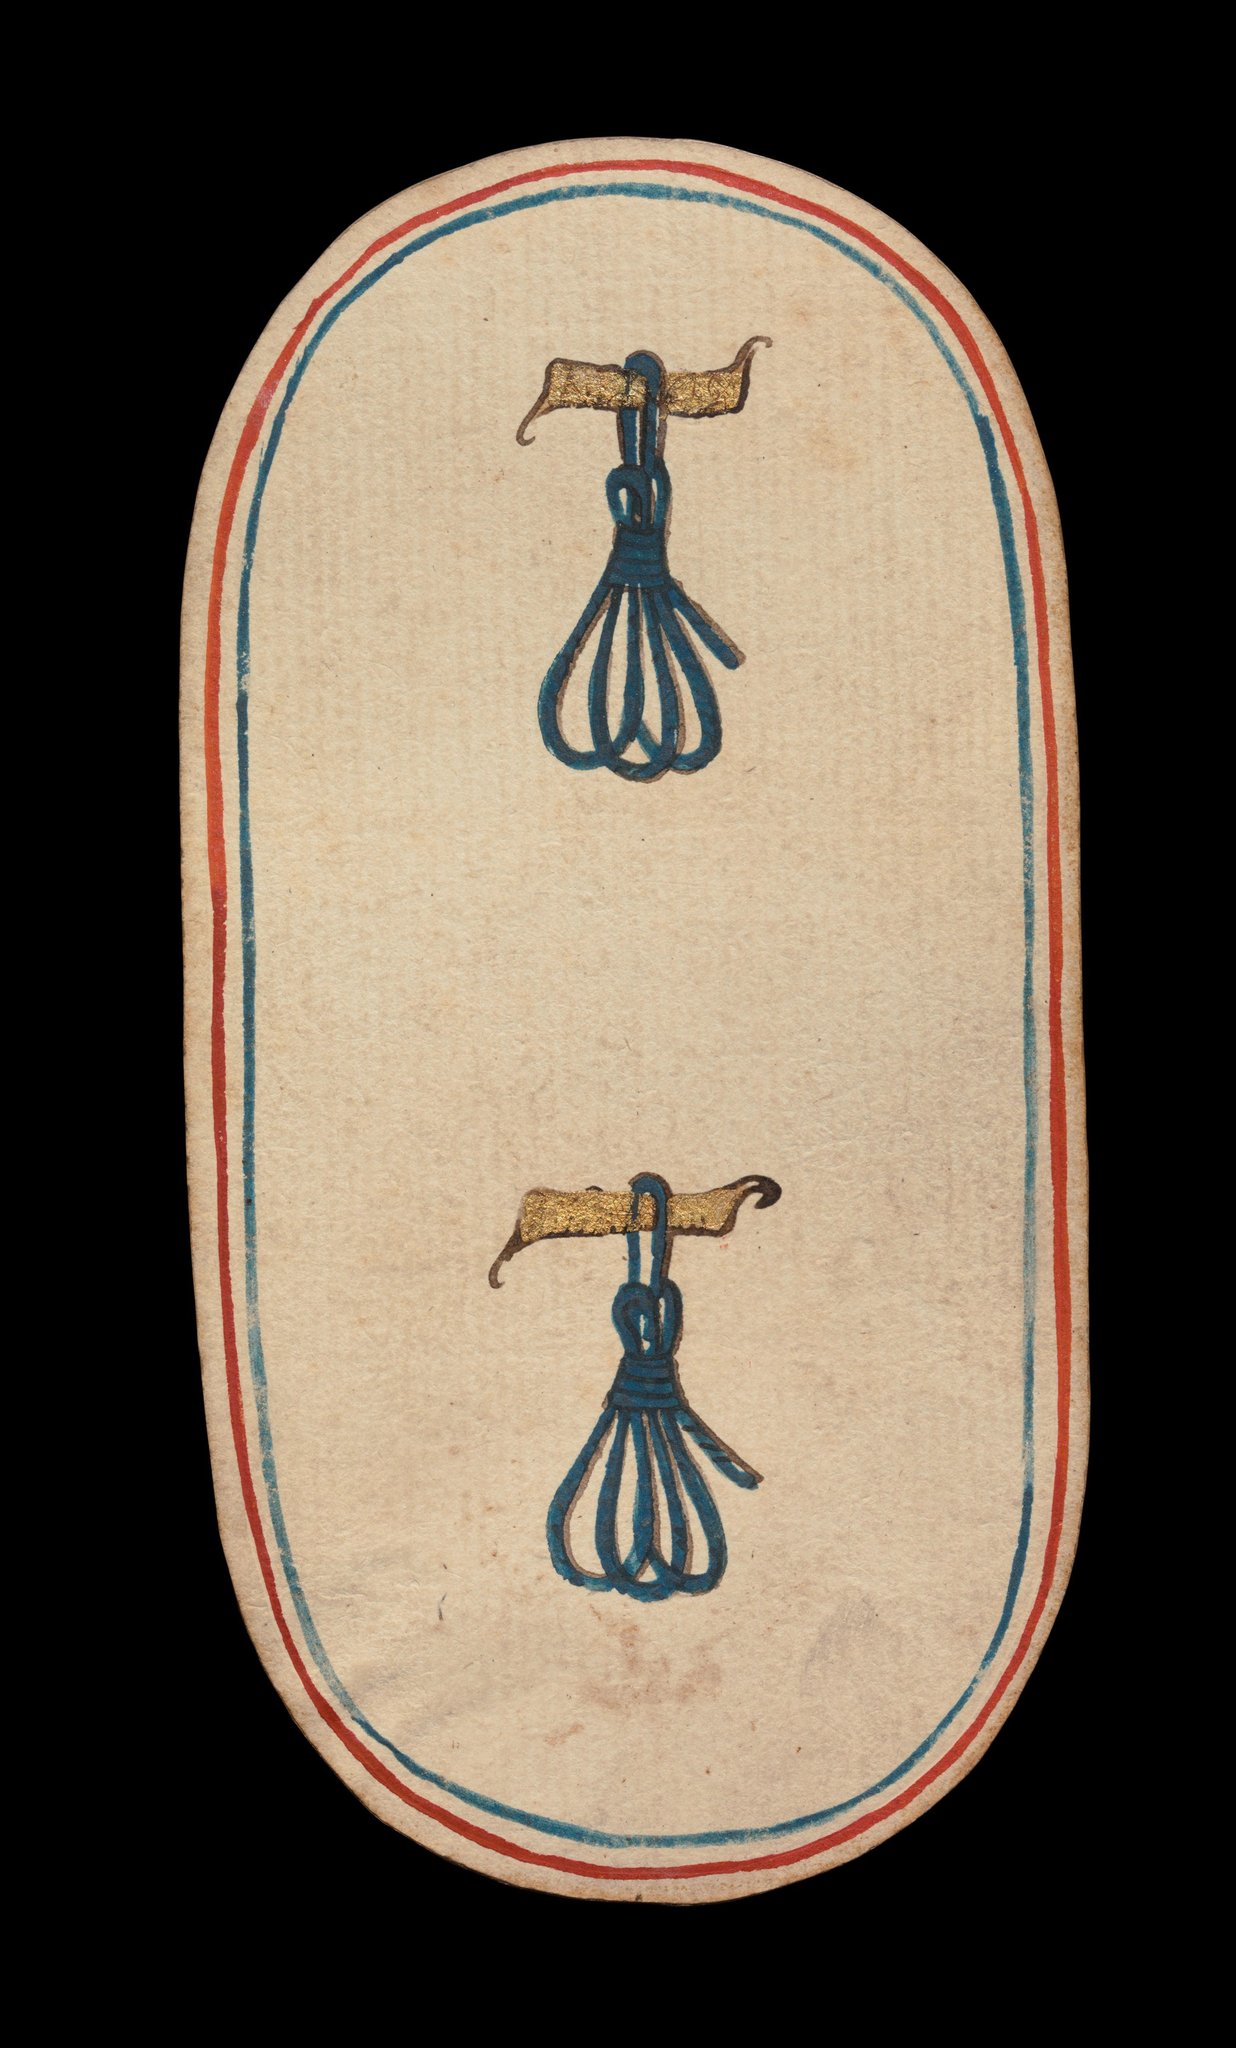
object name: playing card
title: 2 of Tethers, from The Cloisters Playing Cards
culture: south netherlandish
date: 1475-1480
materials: glaze, gold, ink, paint, paper, silver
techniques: pen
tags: playing cards,games